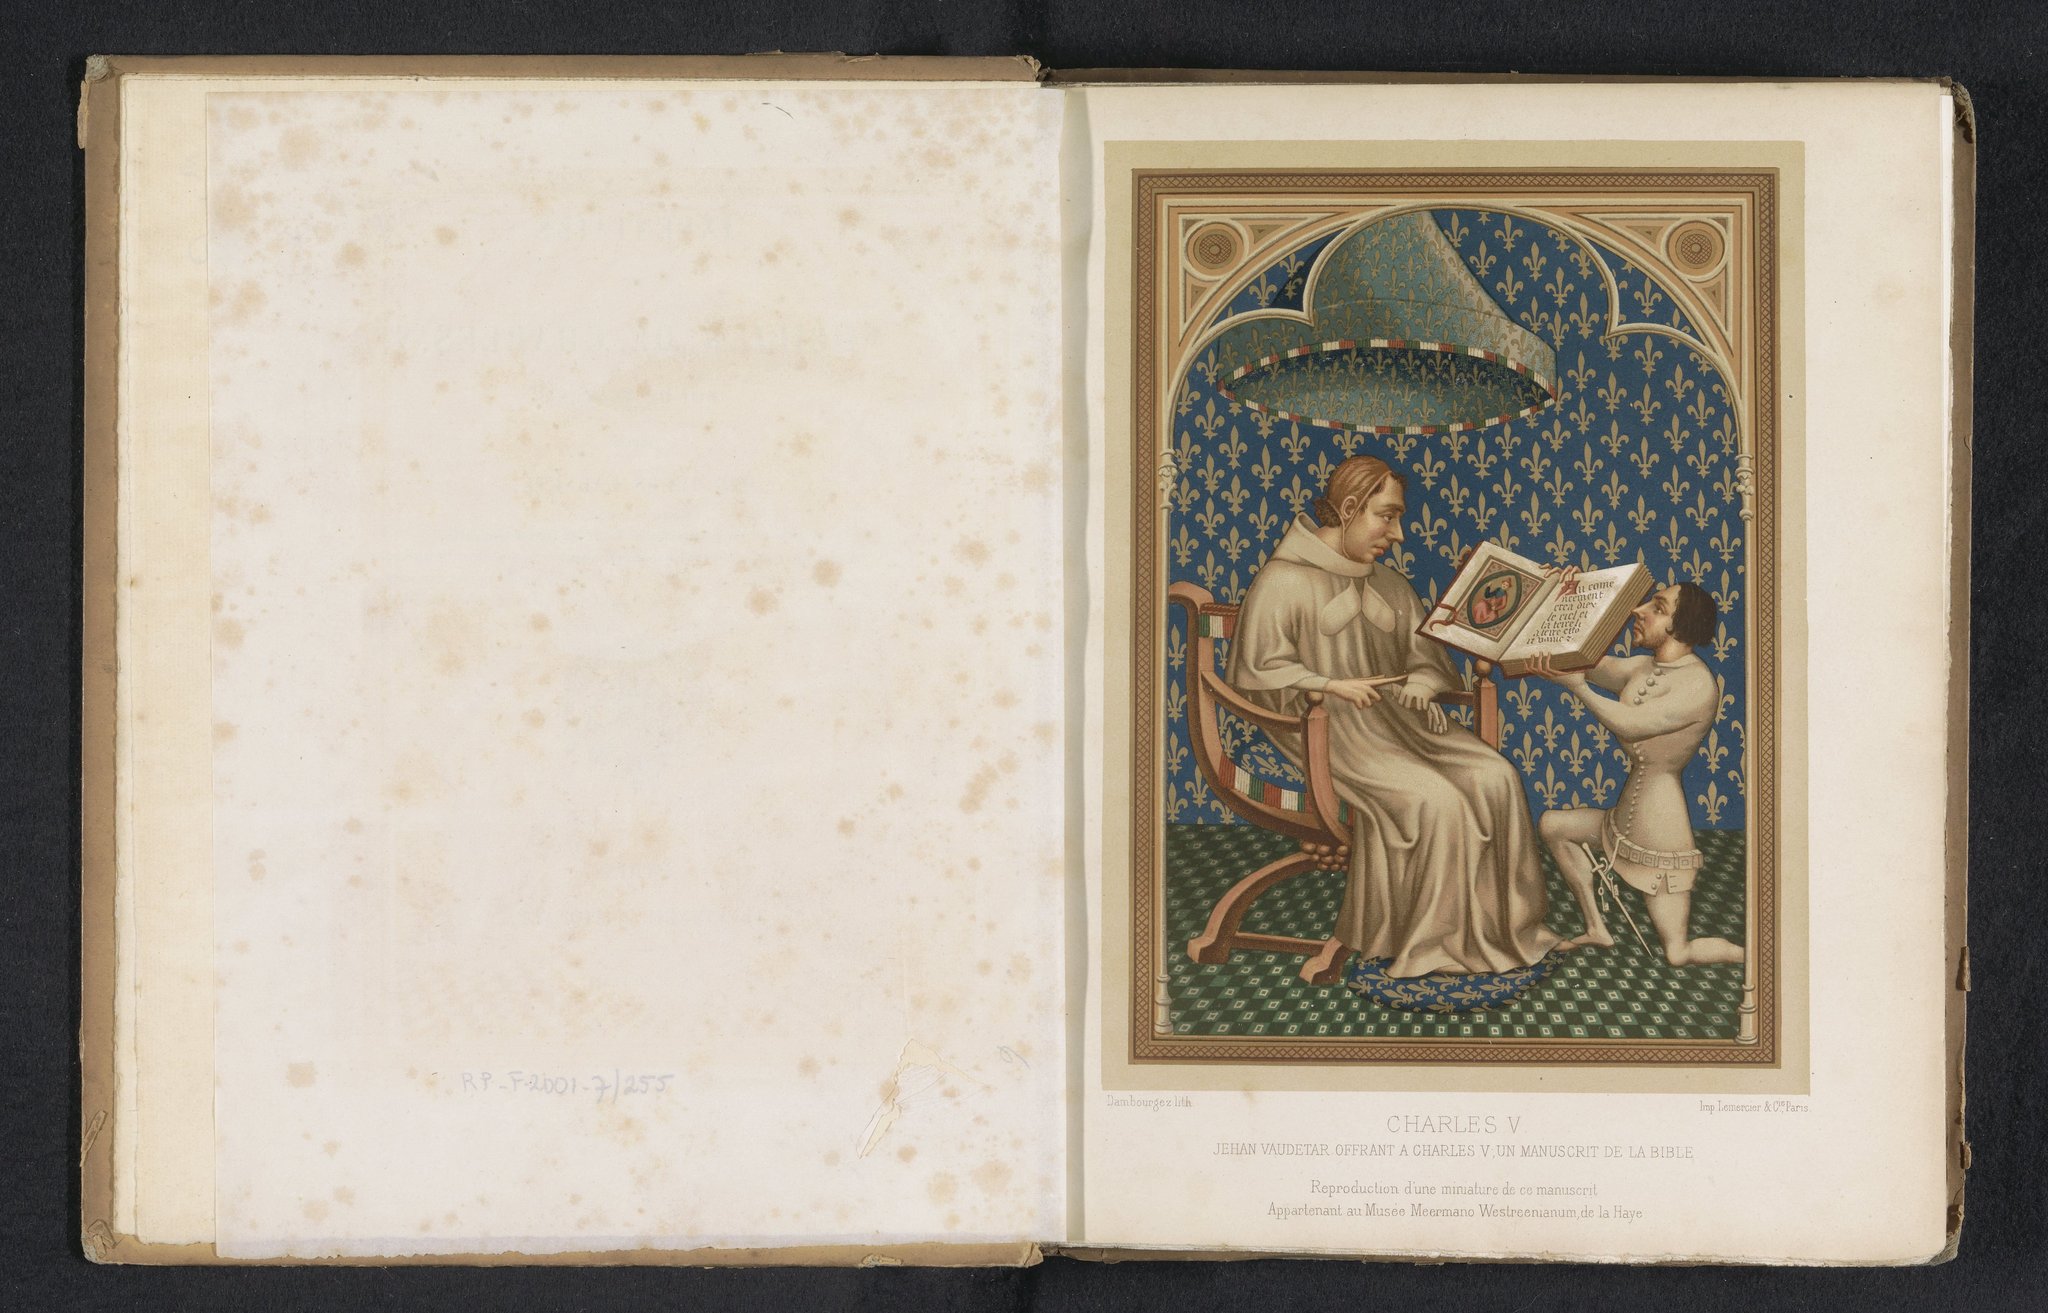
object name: print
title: Jehan Vaudetar offrant a Charles V un maniscrit de la bible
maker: édouard-jean dambourgez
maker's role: painter, print maker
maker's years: 1844-1890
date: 1869-1879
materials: paper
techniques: chromolithography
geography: paris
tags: artist offering his work, 'dedikationsbild'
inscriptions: inscription: ‘Reproduction d'une miniature de ce manuscrit. Appartenant au Musée Meermano Westreenianum de la Haye’